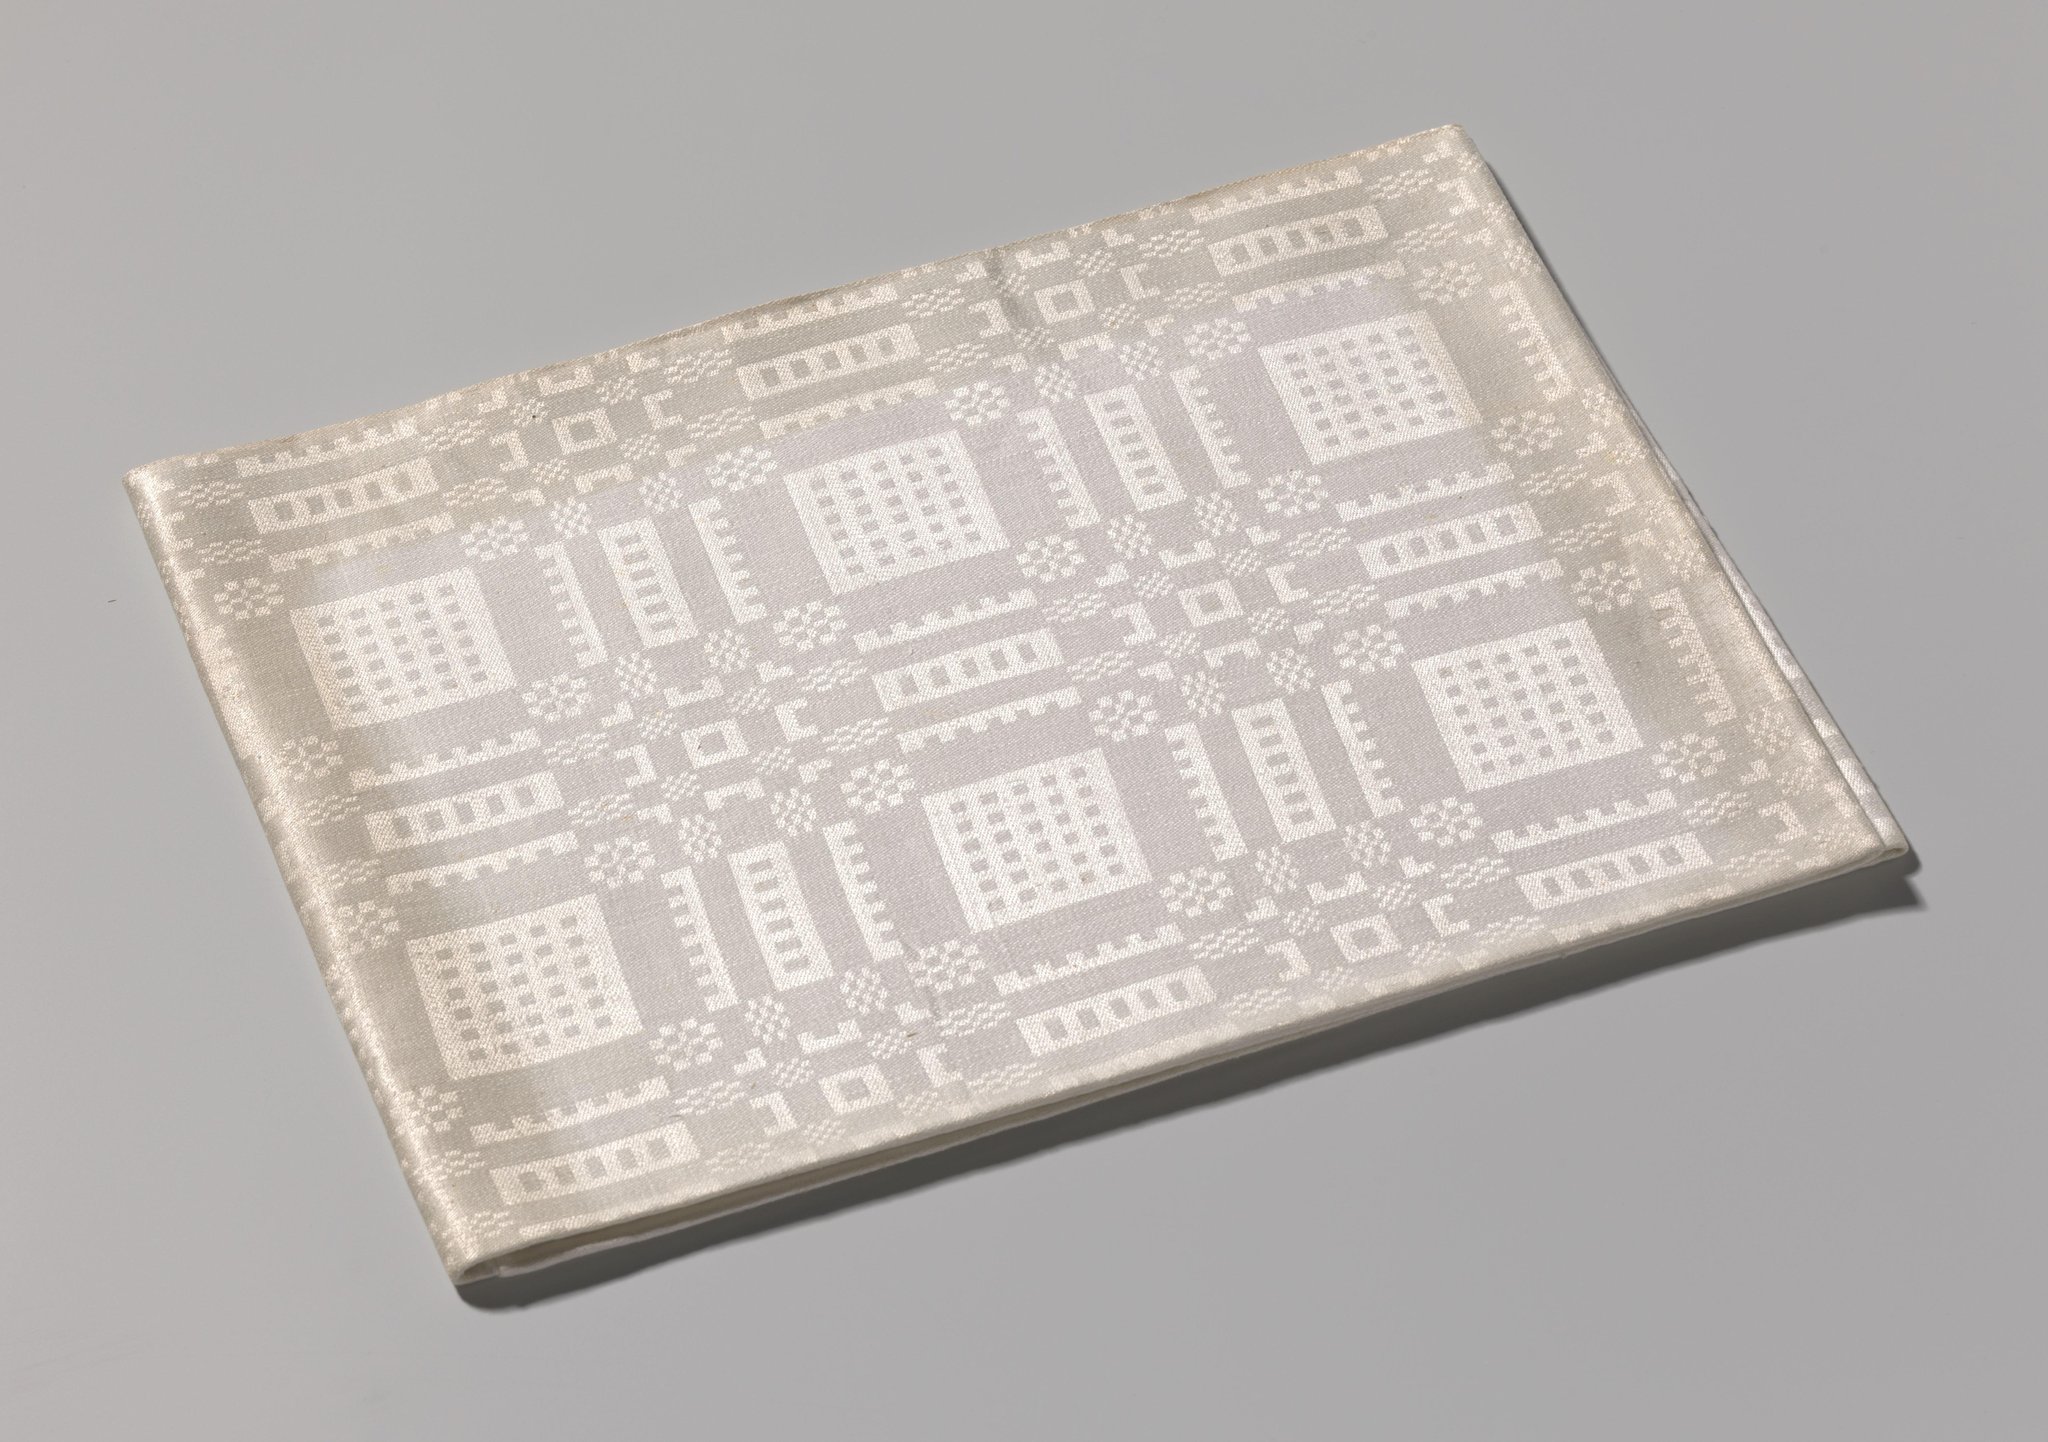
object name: napkin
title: Servet van linnendamast met pellenpatroon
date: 1756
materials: linen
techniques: damask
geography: northern netherlands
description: Servet van wit linnendamast met pellenpatroon, merk kroon G 2 en 1756.